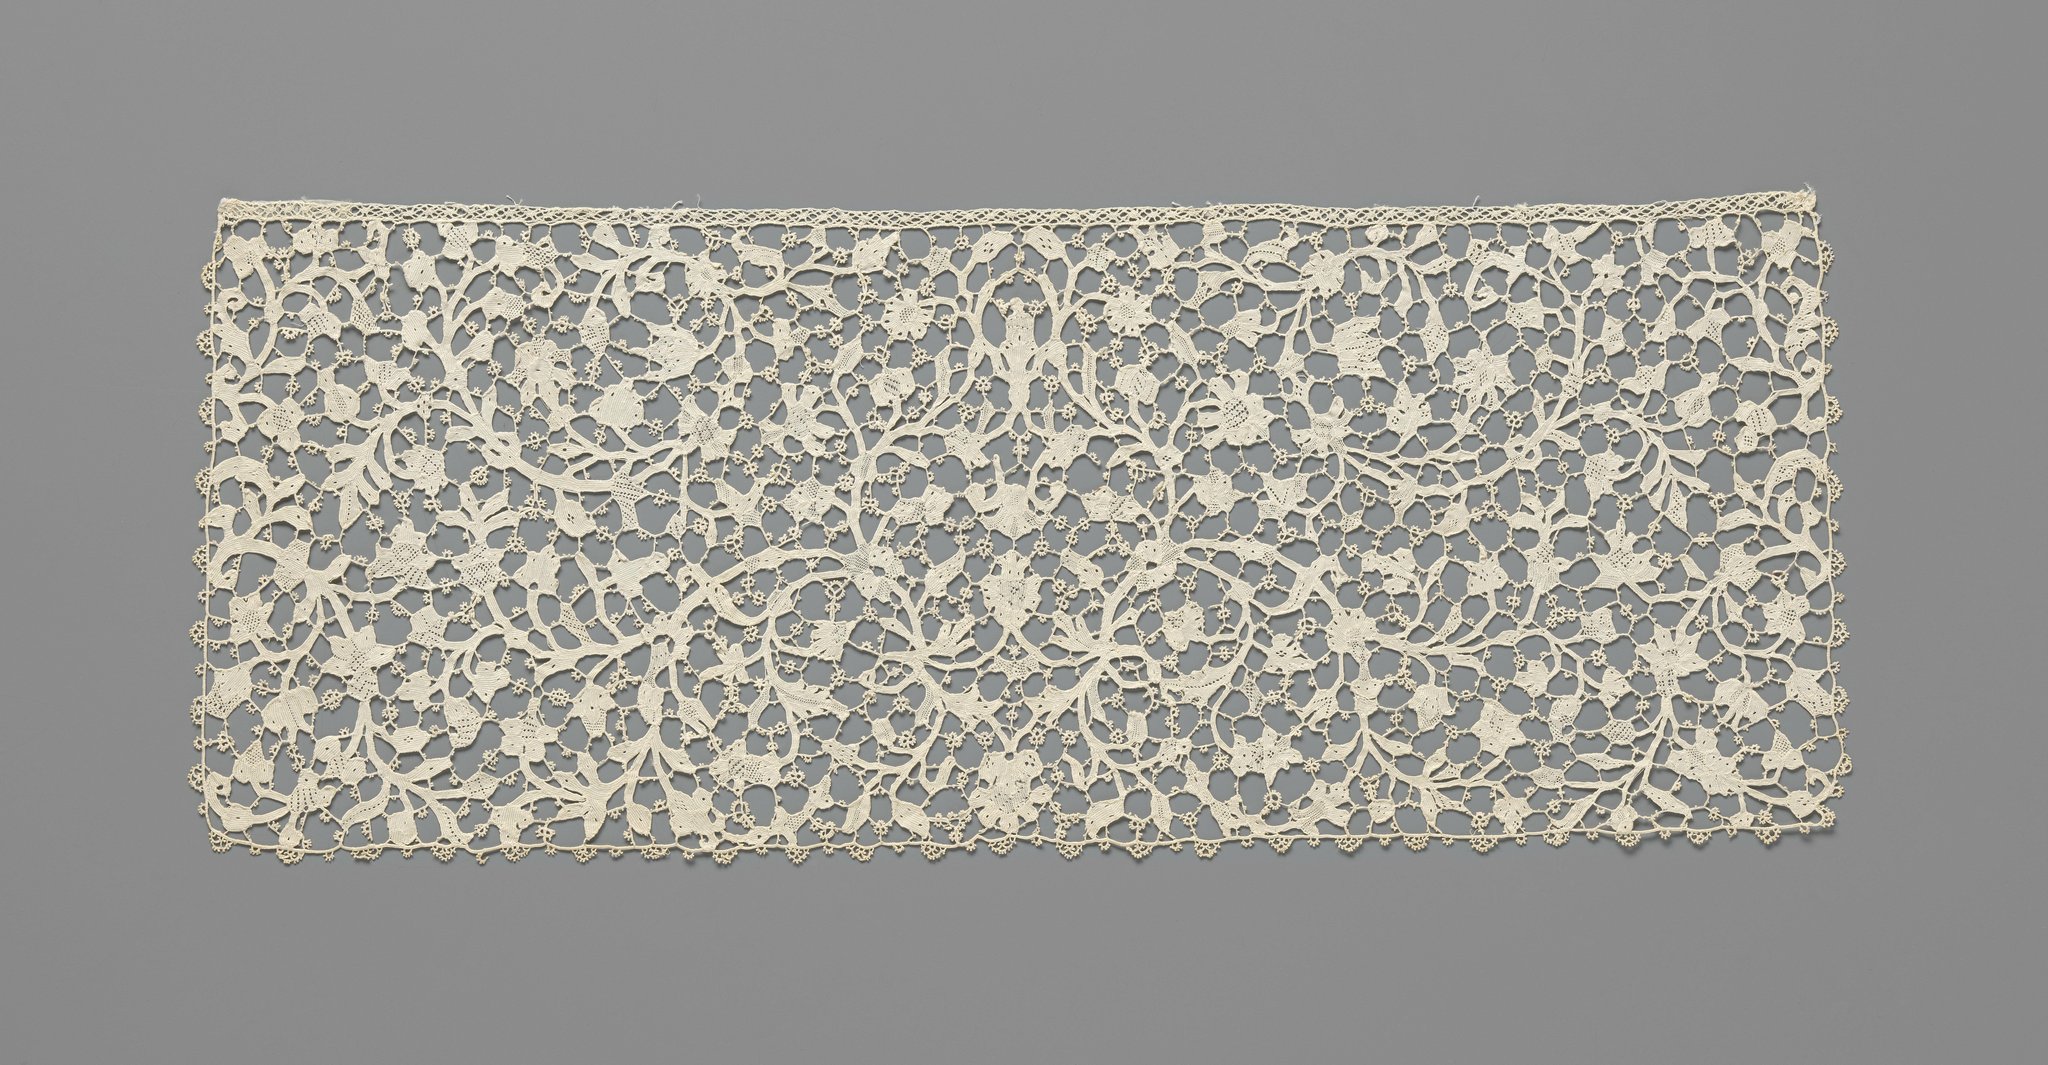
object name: dasslip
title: Slip van naaldkant met een symmetrisch patroon van dunne omkrullende ranken met veelsoortige bloemen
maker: Anonymous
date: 1685-1699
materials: linen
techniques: flat venetian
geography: venice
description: Slip van naturelkleurige naaldkant: platte Venetiaanse kant. Het symmetrische patroon bestaat uit dunne ranken die zich vanuit het midden slingerend voortbewegen en met vele omkrullende vertakkingen eindigen in talrijke bloemsoorten. De slip is afgewerkt met een rechte rand, waarlangs twee soorten gepicoteerde bogen. De motieven zijn met elkaar verbonden door spijlen met picots.